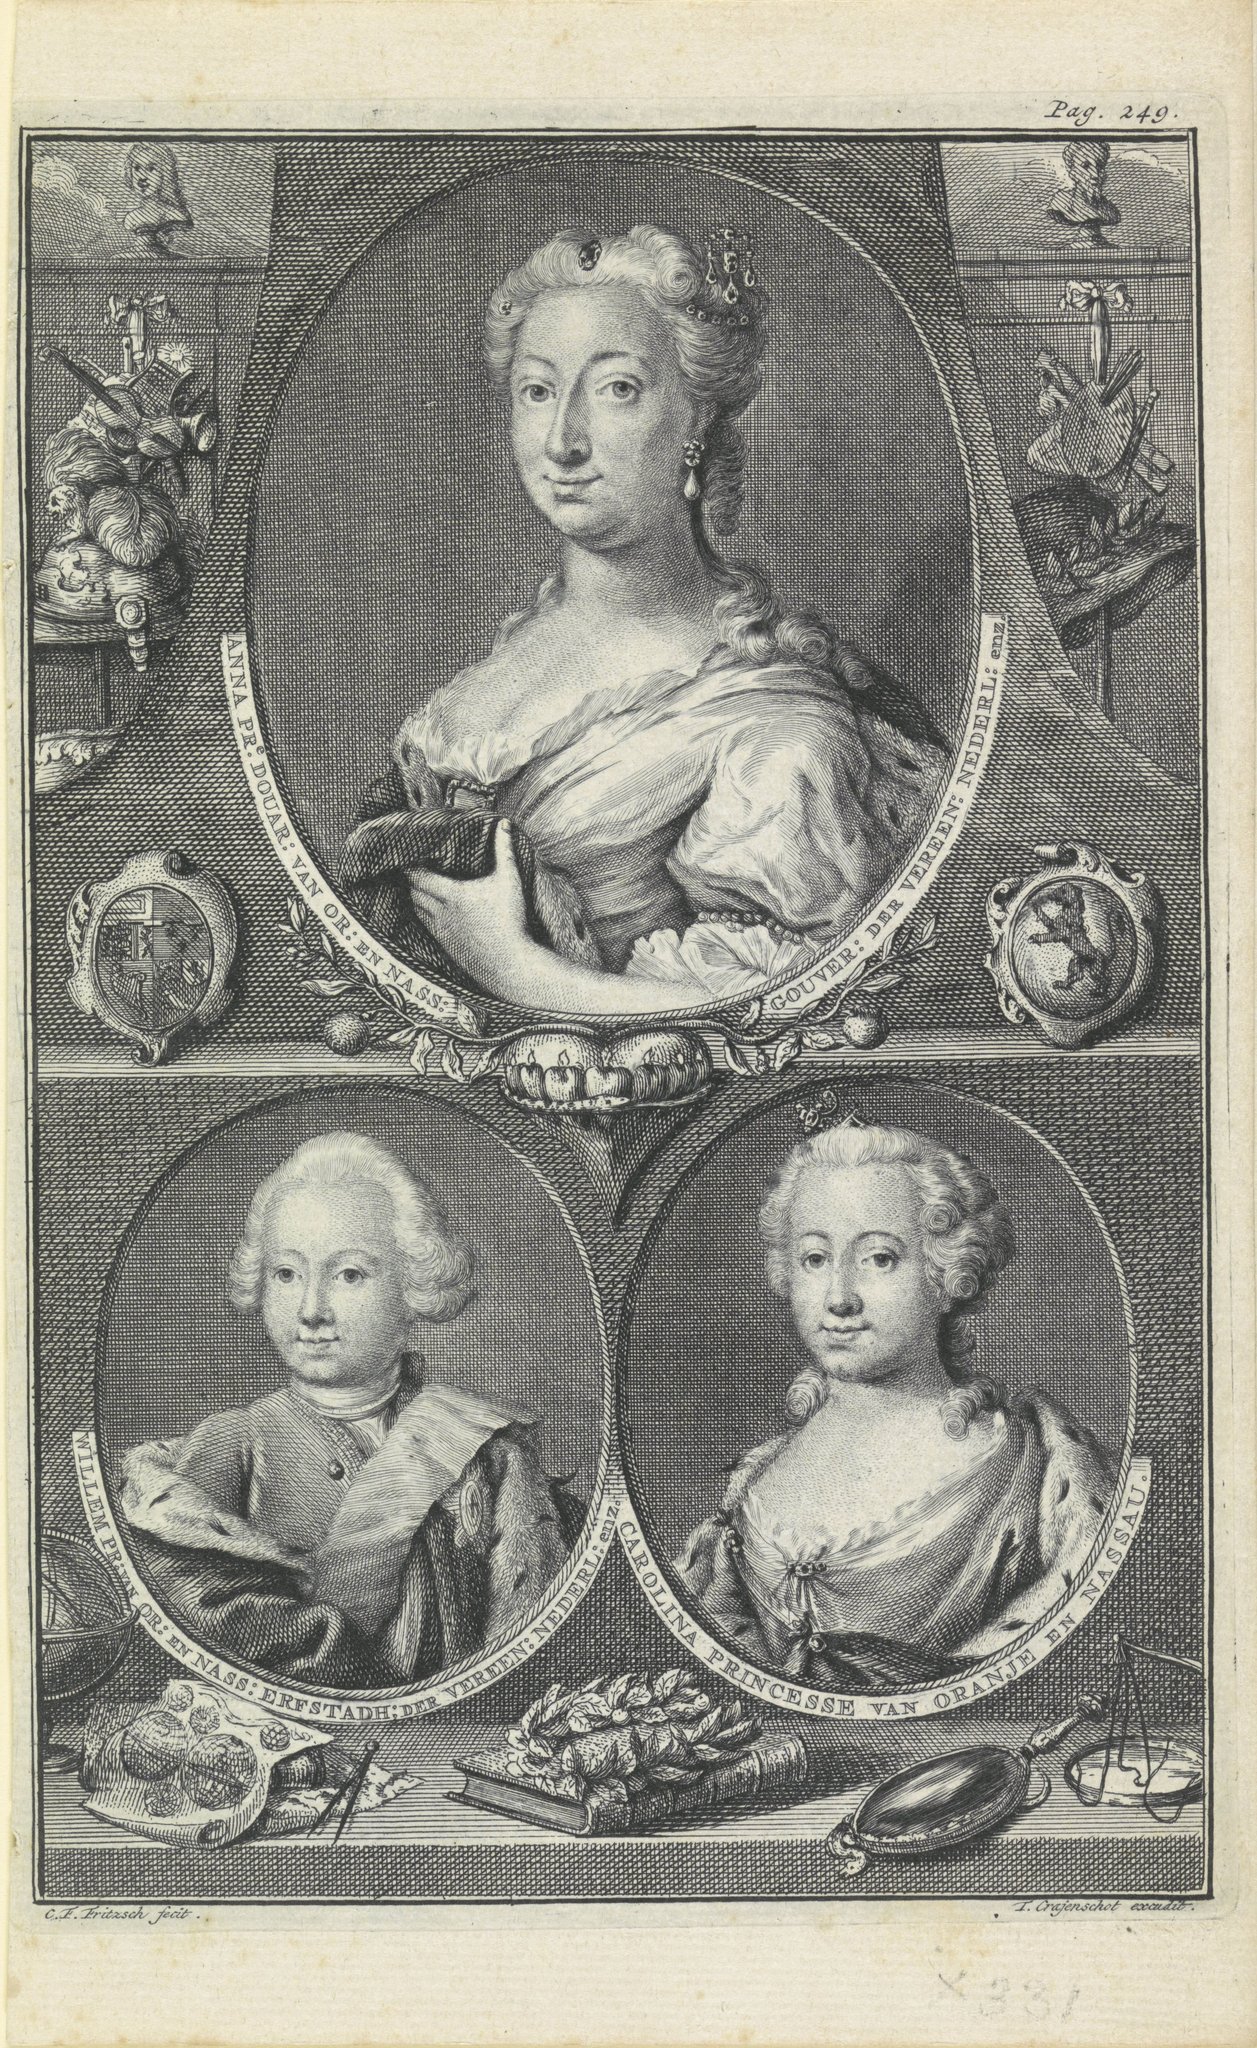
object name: print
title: Portretten van Anna van Hannover, Willem V, prins van Oranje-Nassau, en Carolina, prinses van Oranje-Nassau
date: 1751-1803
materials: paper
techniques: engraving, etching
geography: amsterdam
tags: william v (prince of orange), carolina (prinses van oranje-nassau), anna van hannover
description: De hier vermelde titel verwijst naar de hoogst verkregen titel van de geportretteerde, niet per se naar de titel die de geportretteerde op deze voorstelling draagt.